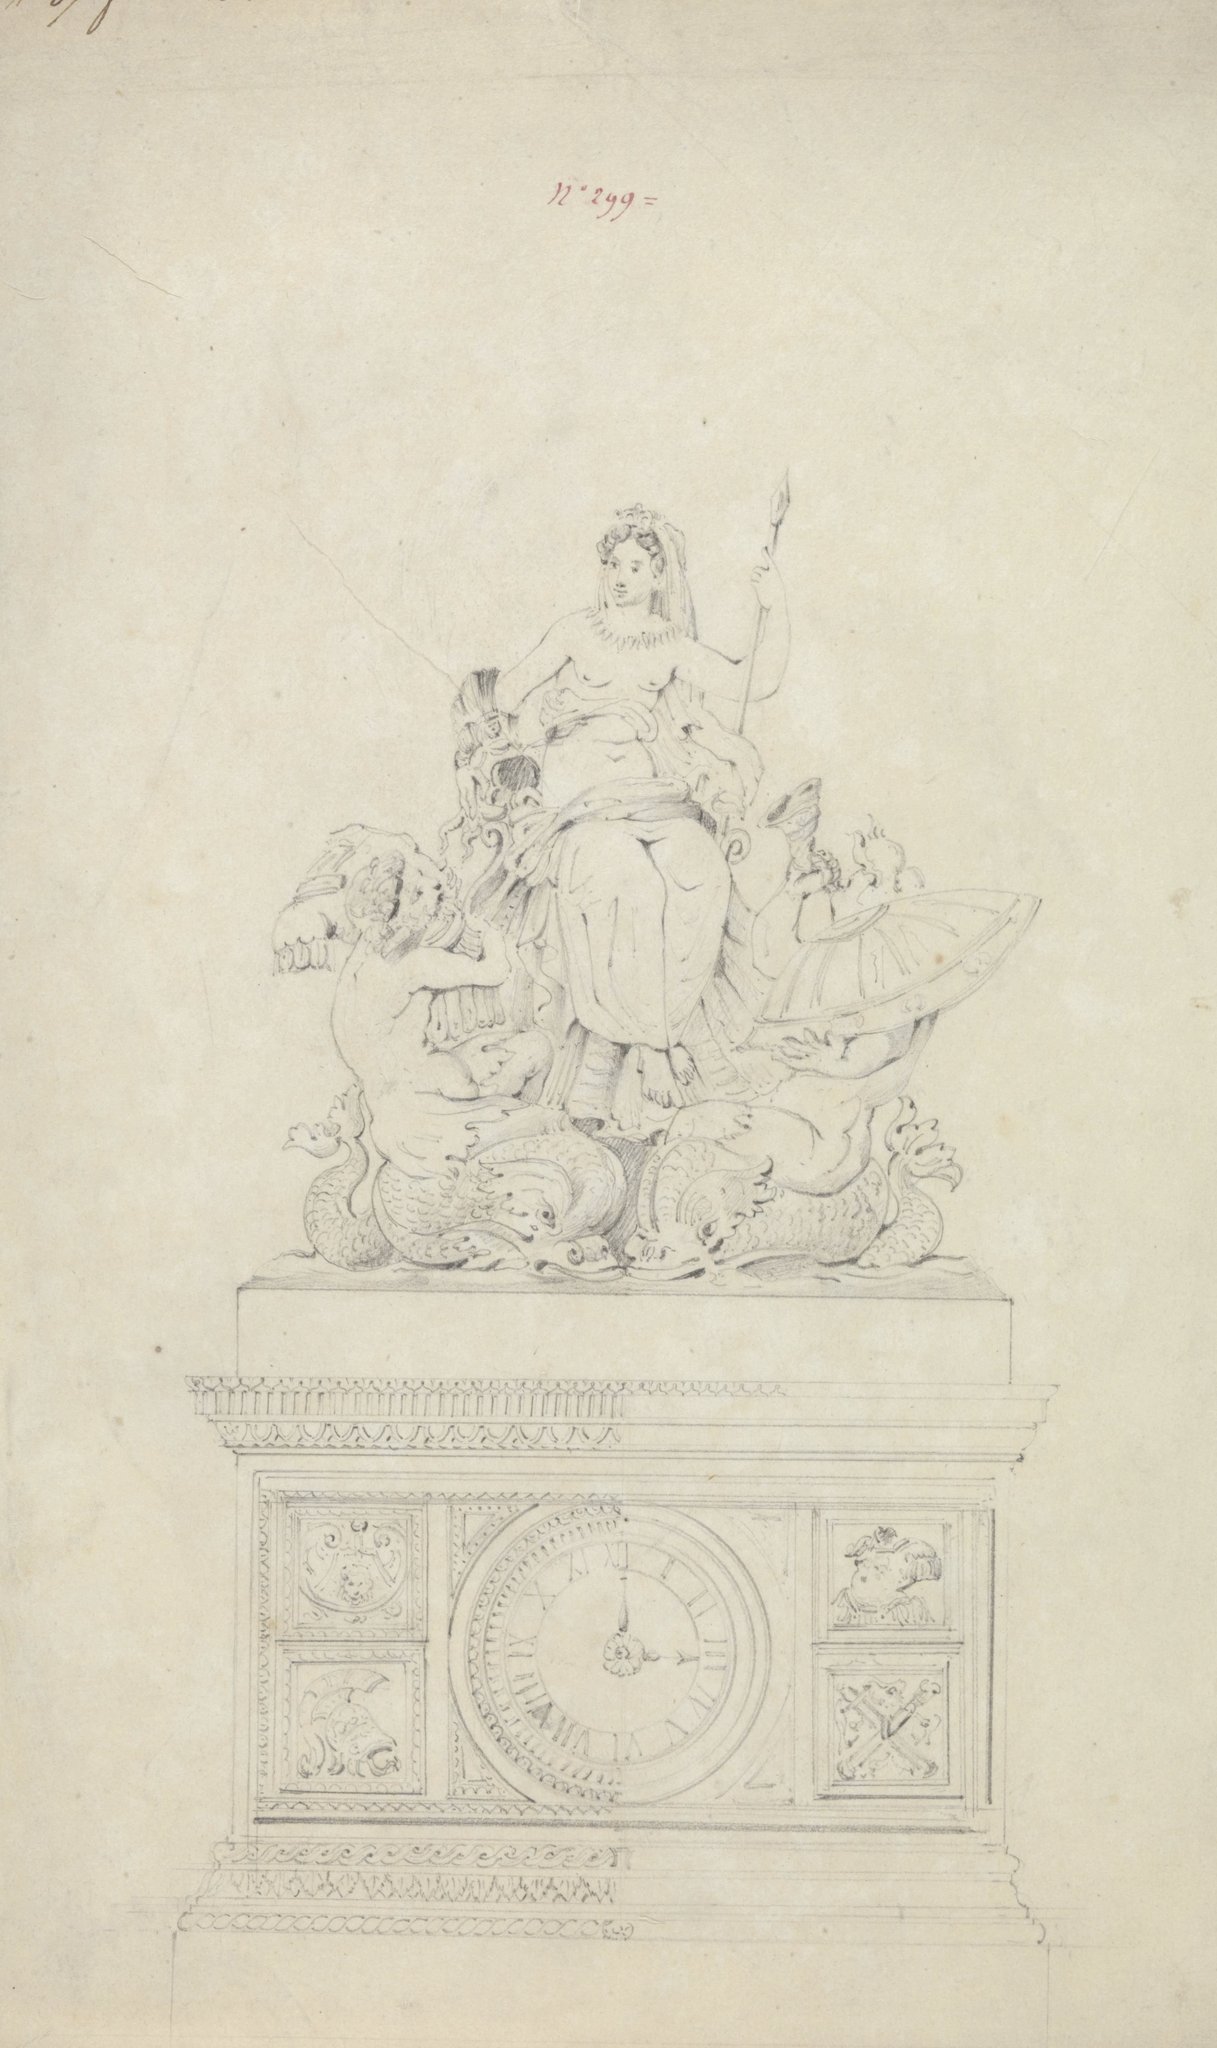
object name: design drawing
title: Ontwerp voor een pendule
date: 1830-1834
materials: graphite, ink, paper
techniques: pen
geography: france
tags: clock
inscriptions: inscription: ‘N° 299’, inscription: ‘N° 67 f.l.2.1834’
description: Ontwerp voor een pendule bekroond met een personificatie van Bellona en twee zeewezens gezeten op dolfijnen.